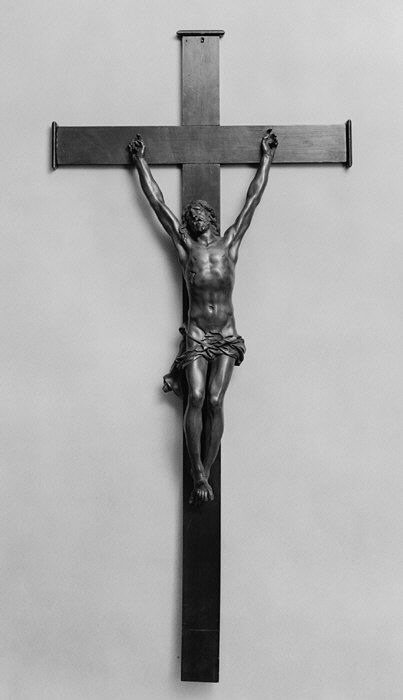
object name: crucifix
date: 1601-1700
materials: wood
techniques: polish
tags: christ,cross,crucifixion